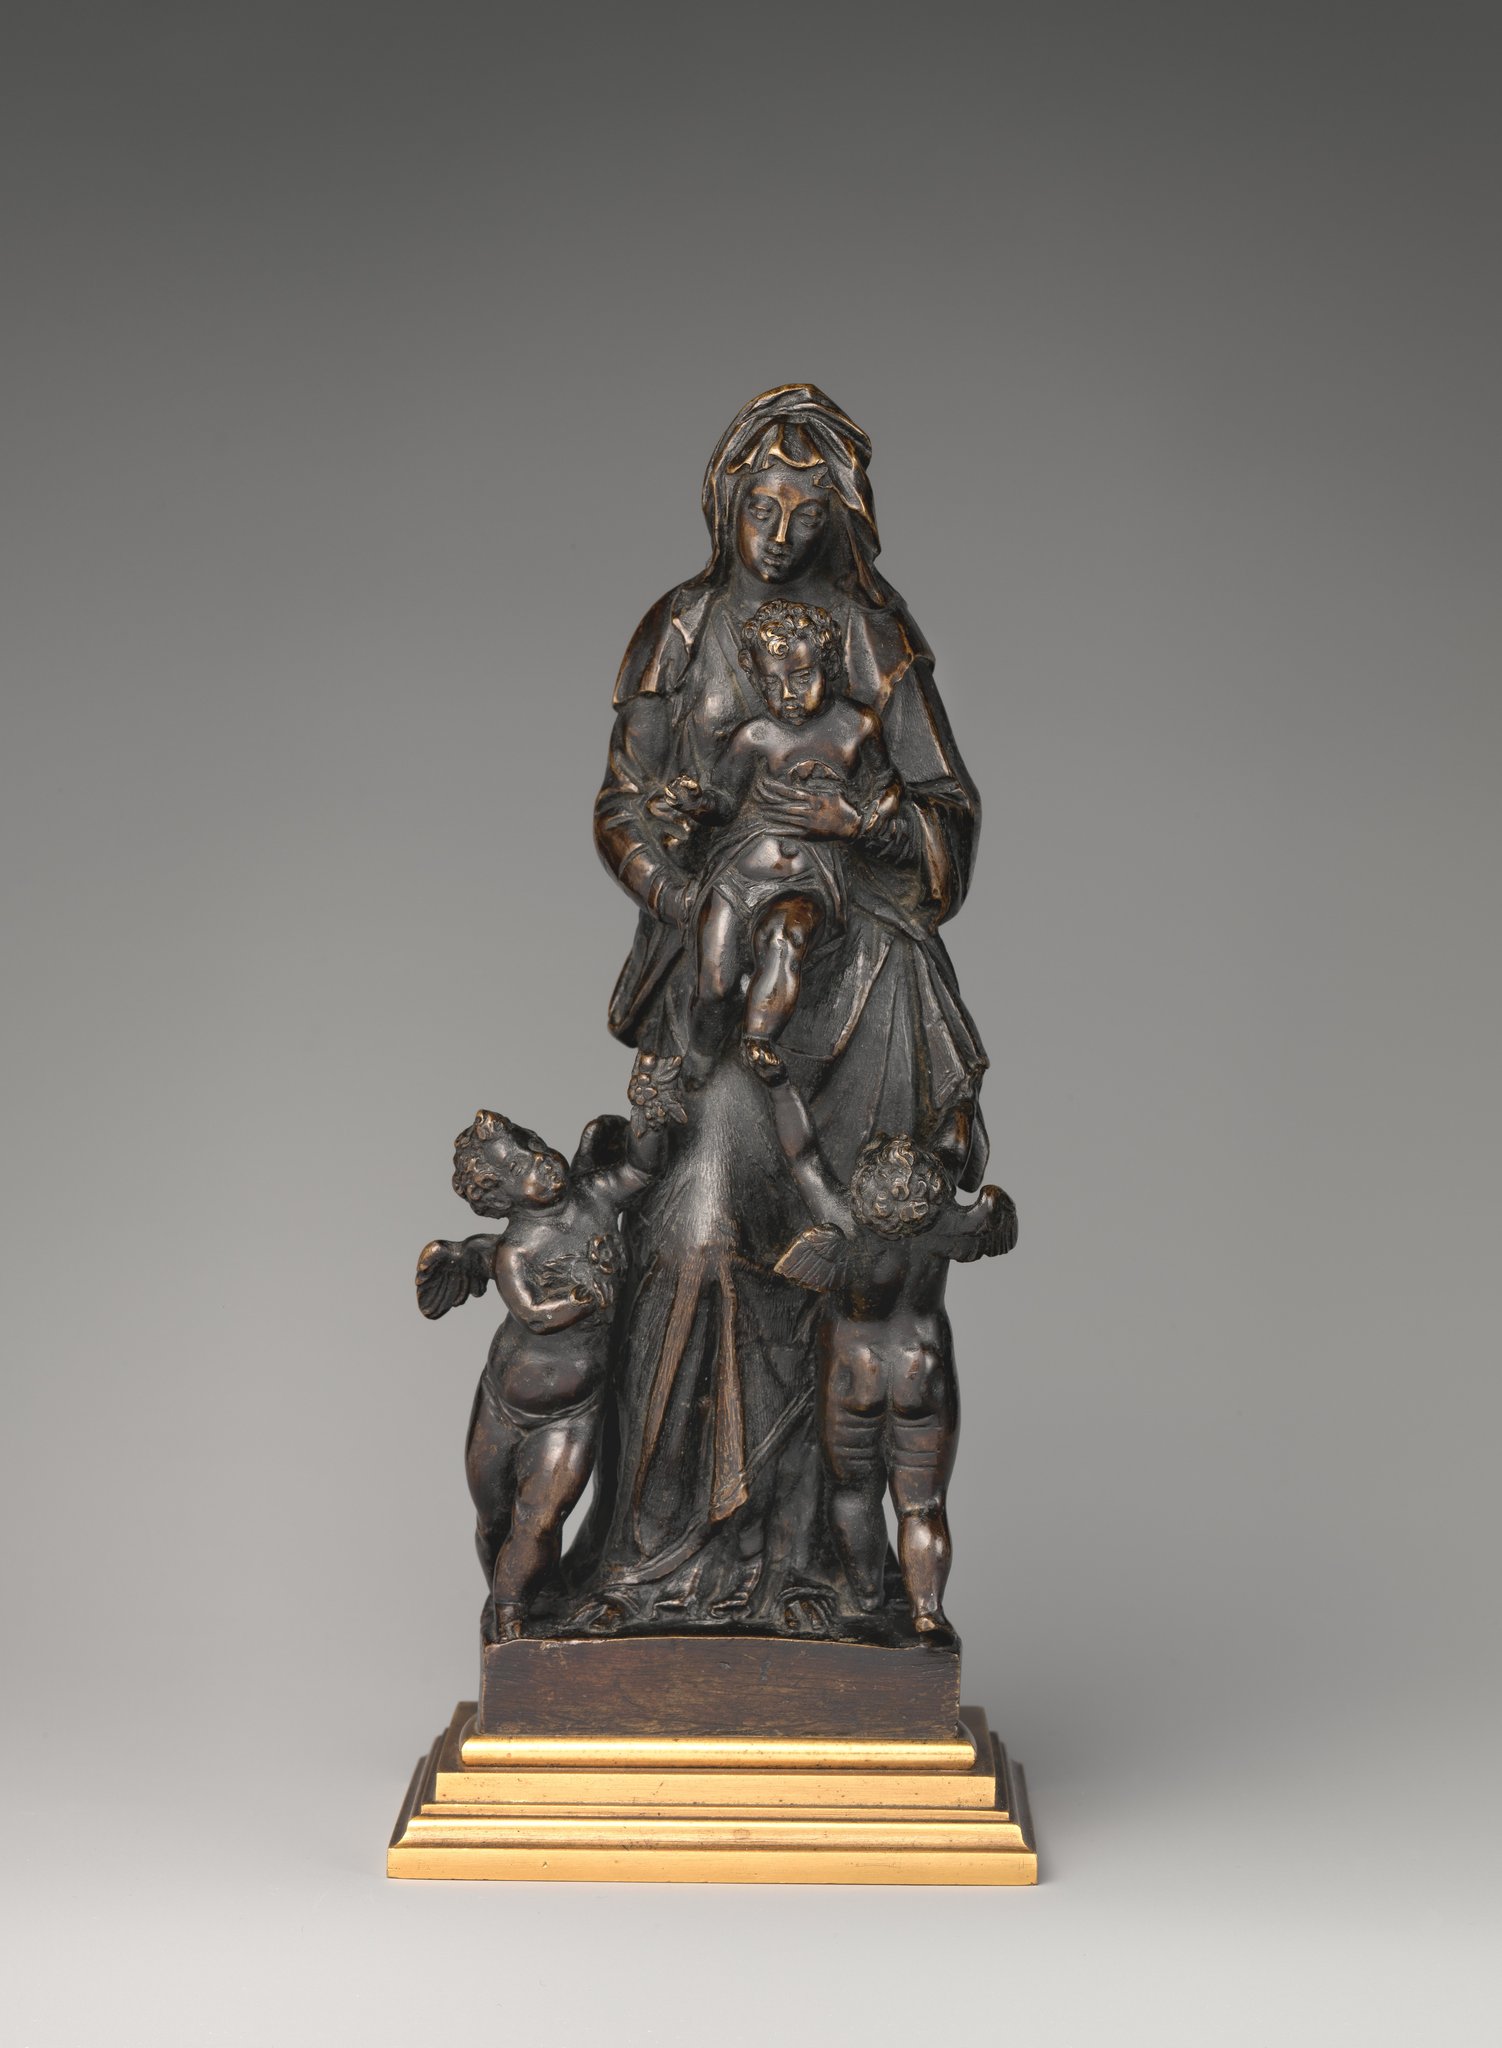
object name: statuette group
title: Virgin and child with angels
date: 1630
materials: bronze, gilt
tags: angels,madonna and child